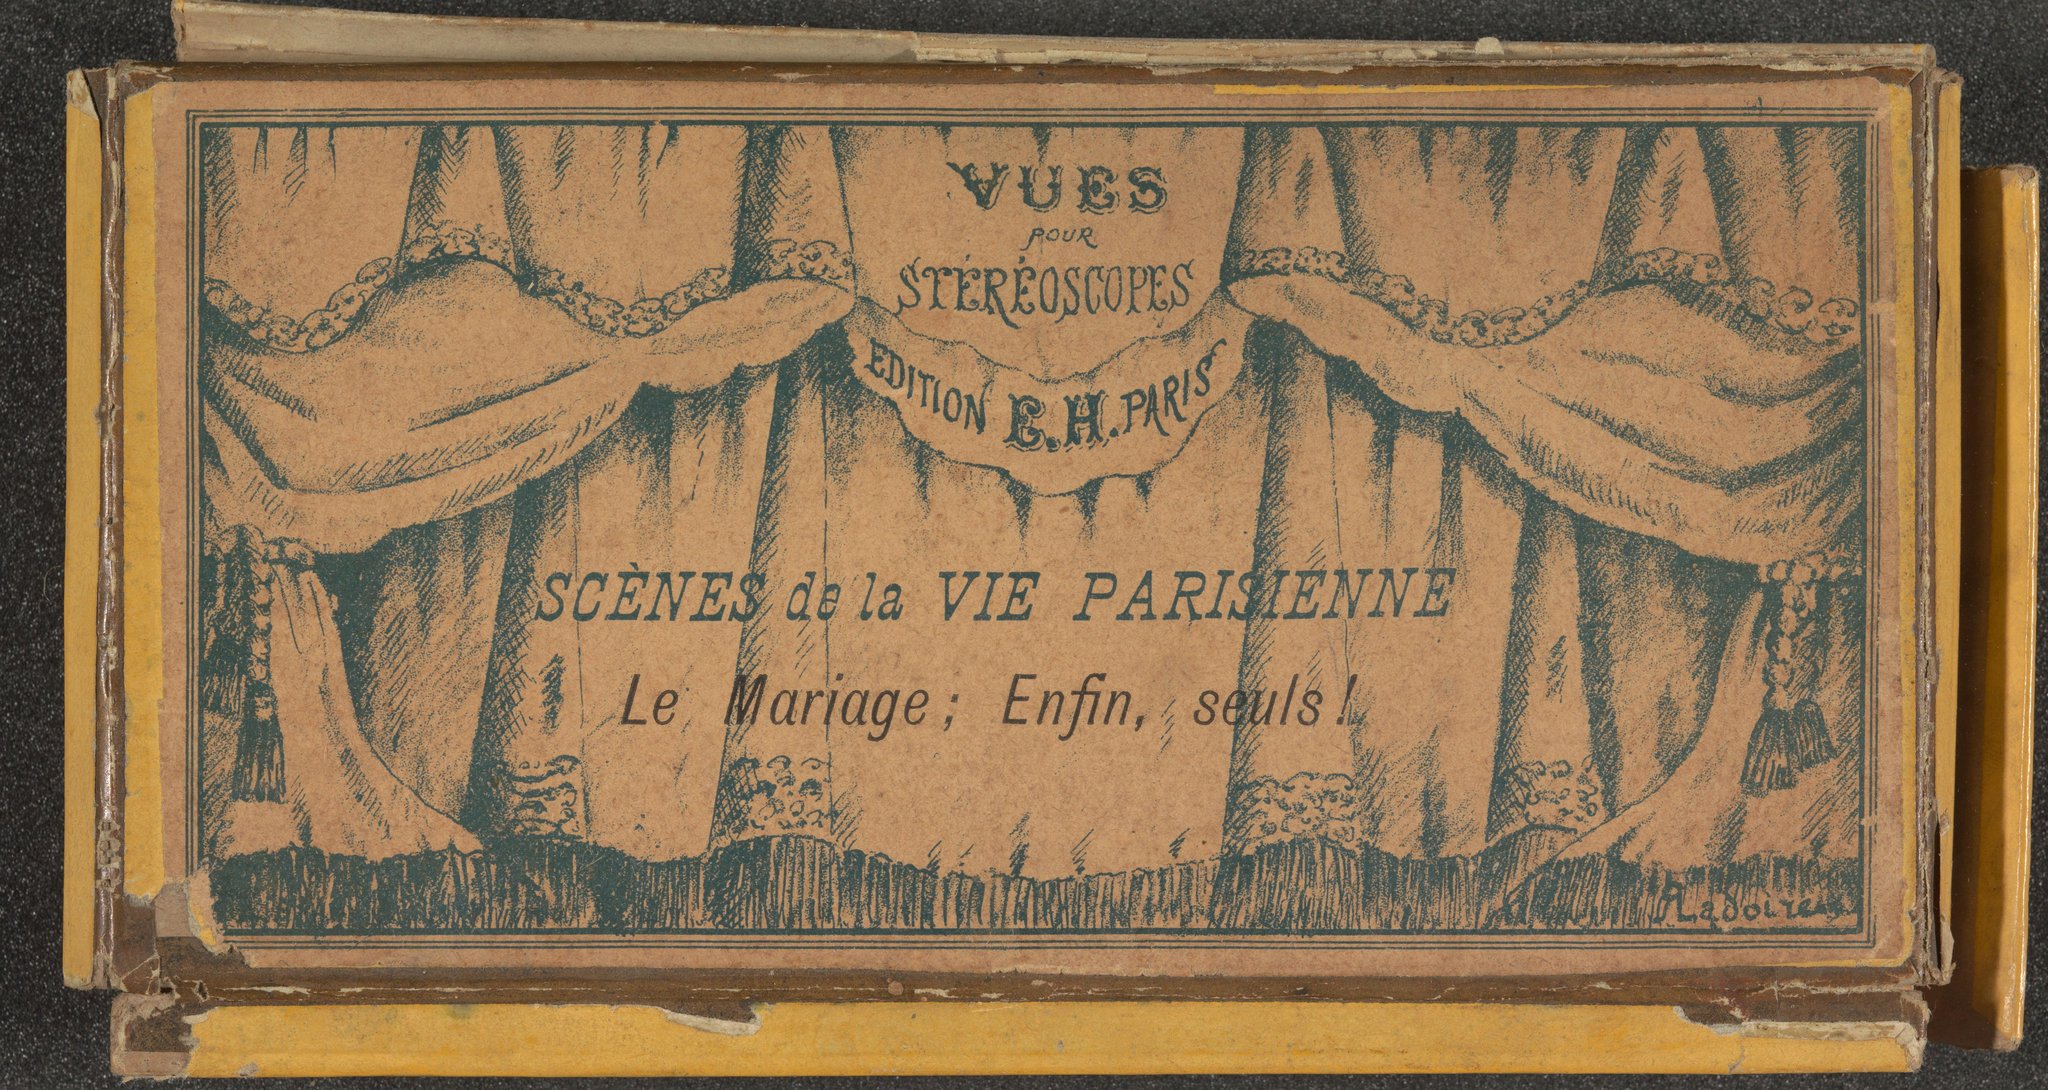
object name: box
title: Le Mariage; Enfin, seuls!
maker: eugène hanau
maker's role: publisher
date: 1870-1890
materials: cardboard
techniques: albumen print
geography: paris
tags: paris